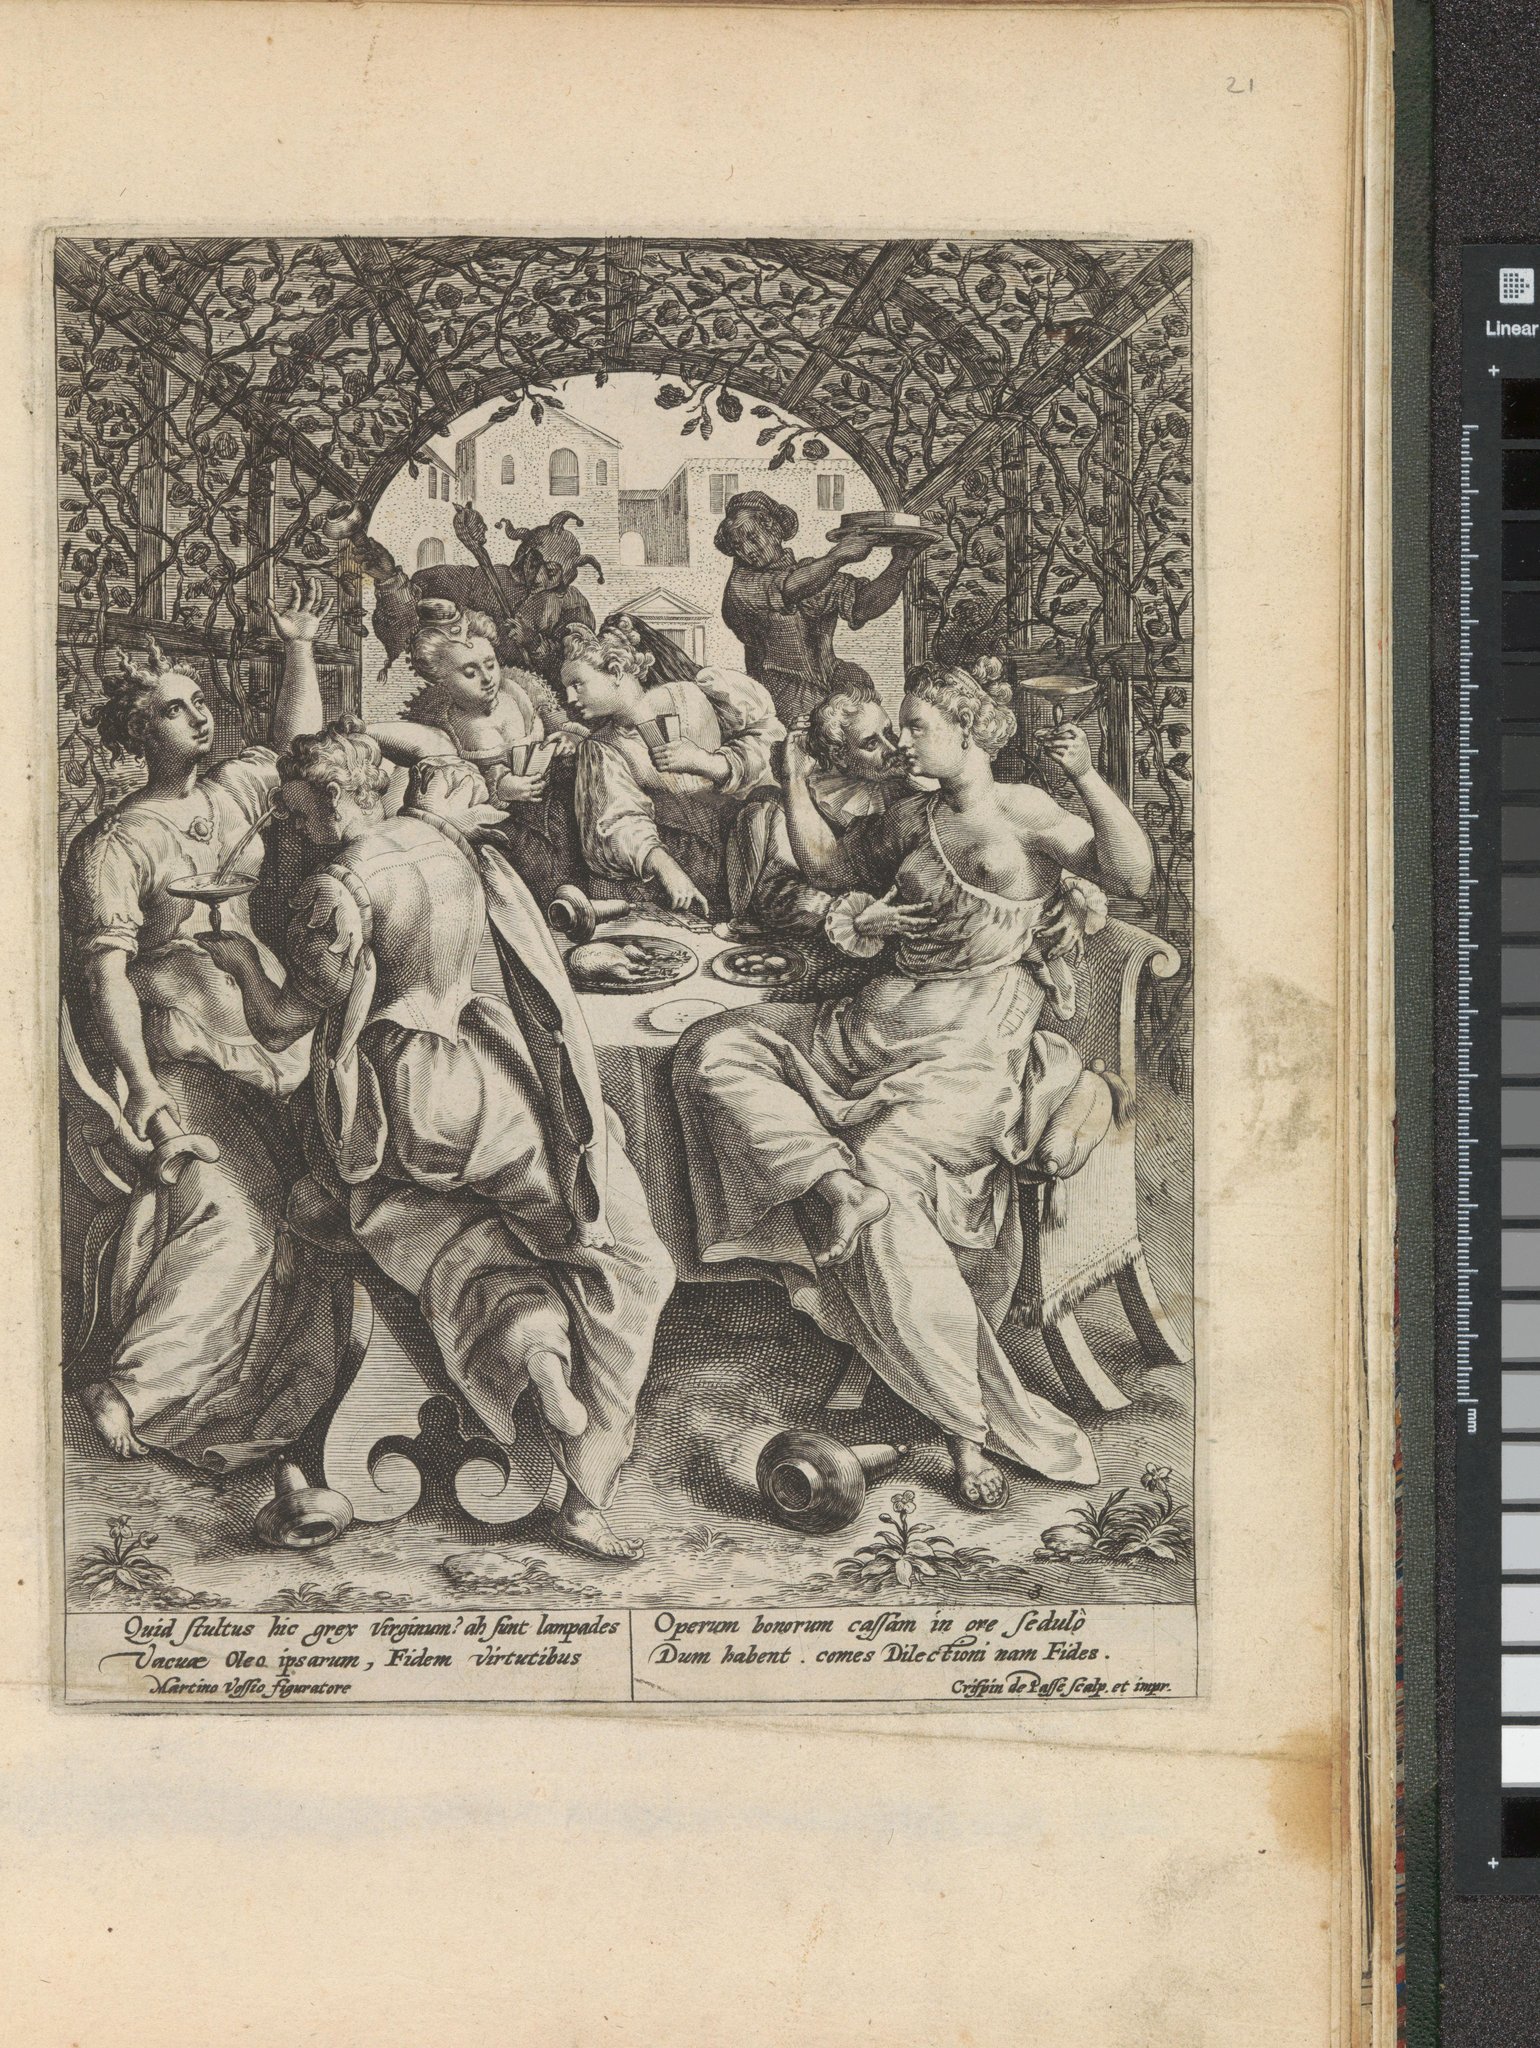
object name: album leaf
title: Parabola V. Virginvm Typis Aen: Expressa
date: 1589-1611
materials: paper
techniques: engraving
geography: cologne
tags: court jester, court fool, the wise and the foolish virgins ~ parable of christ (matthew 25:1-13)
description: De vijf dwaze maagden zitten rond een tafel onder een pergola. Ze eten, drinken, spelen kaart en vrijen. Hun olielampen liggen uitgedoofd op de grond. Op de achtergrond een nar als symbool van dwaasheid. In de marge een vierregelig onderschrift, in twee kolommen, in het Latijn dat verwijst naar het Bijbelverhaal. Deze prent maakt deel uit van een album.